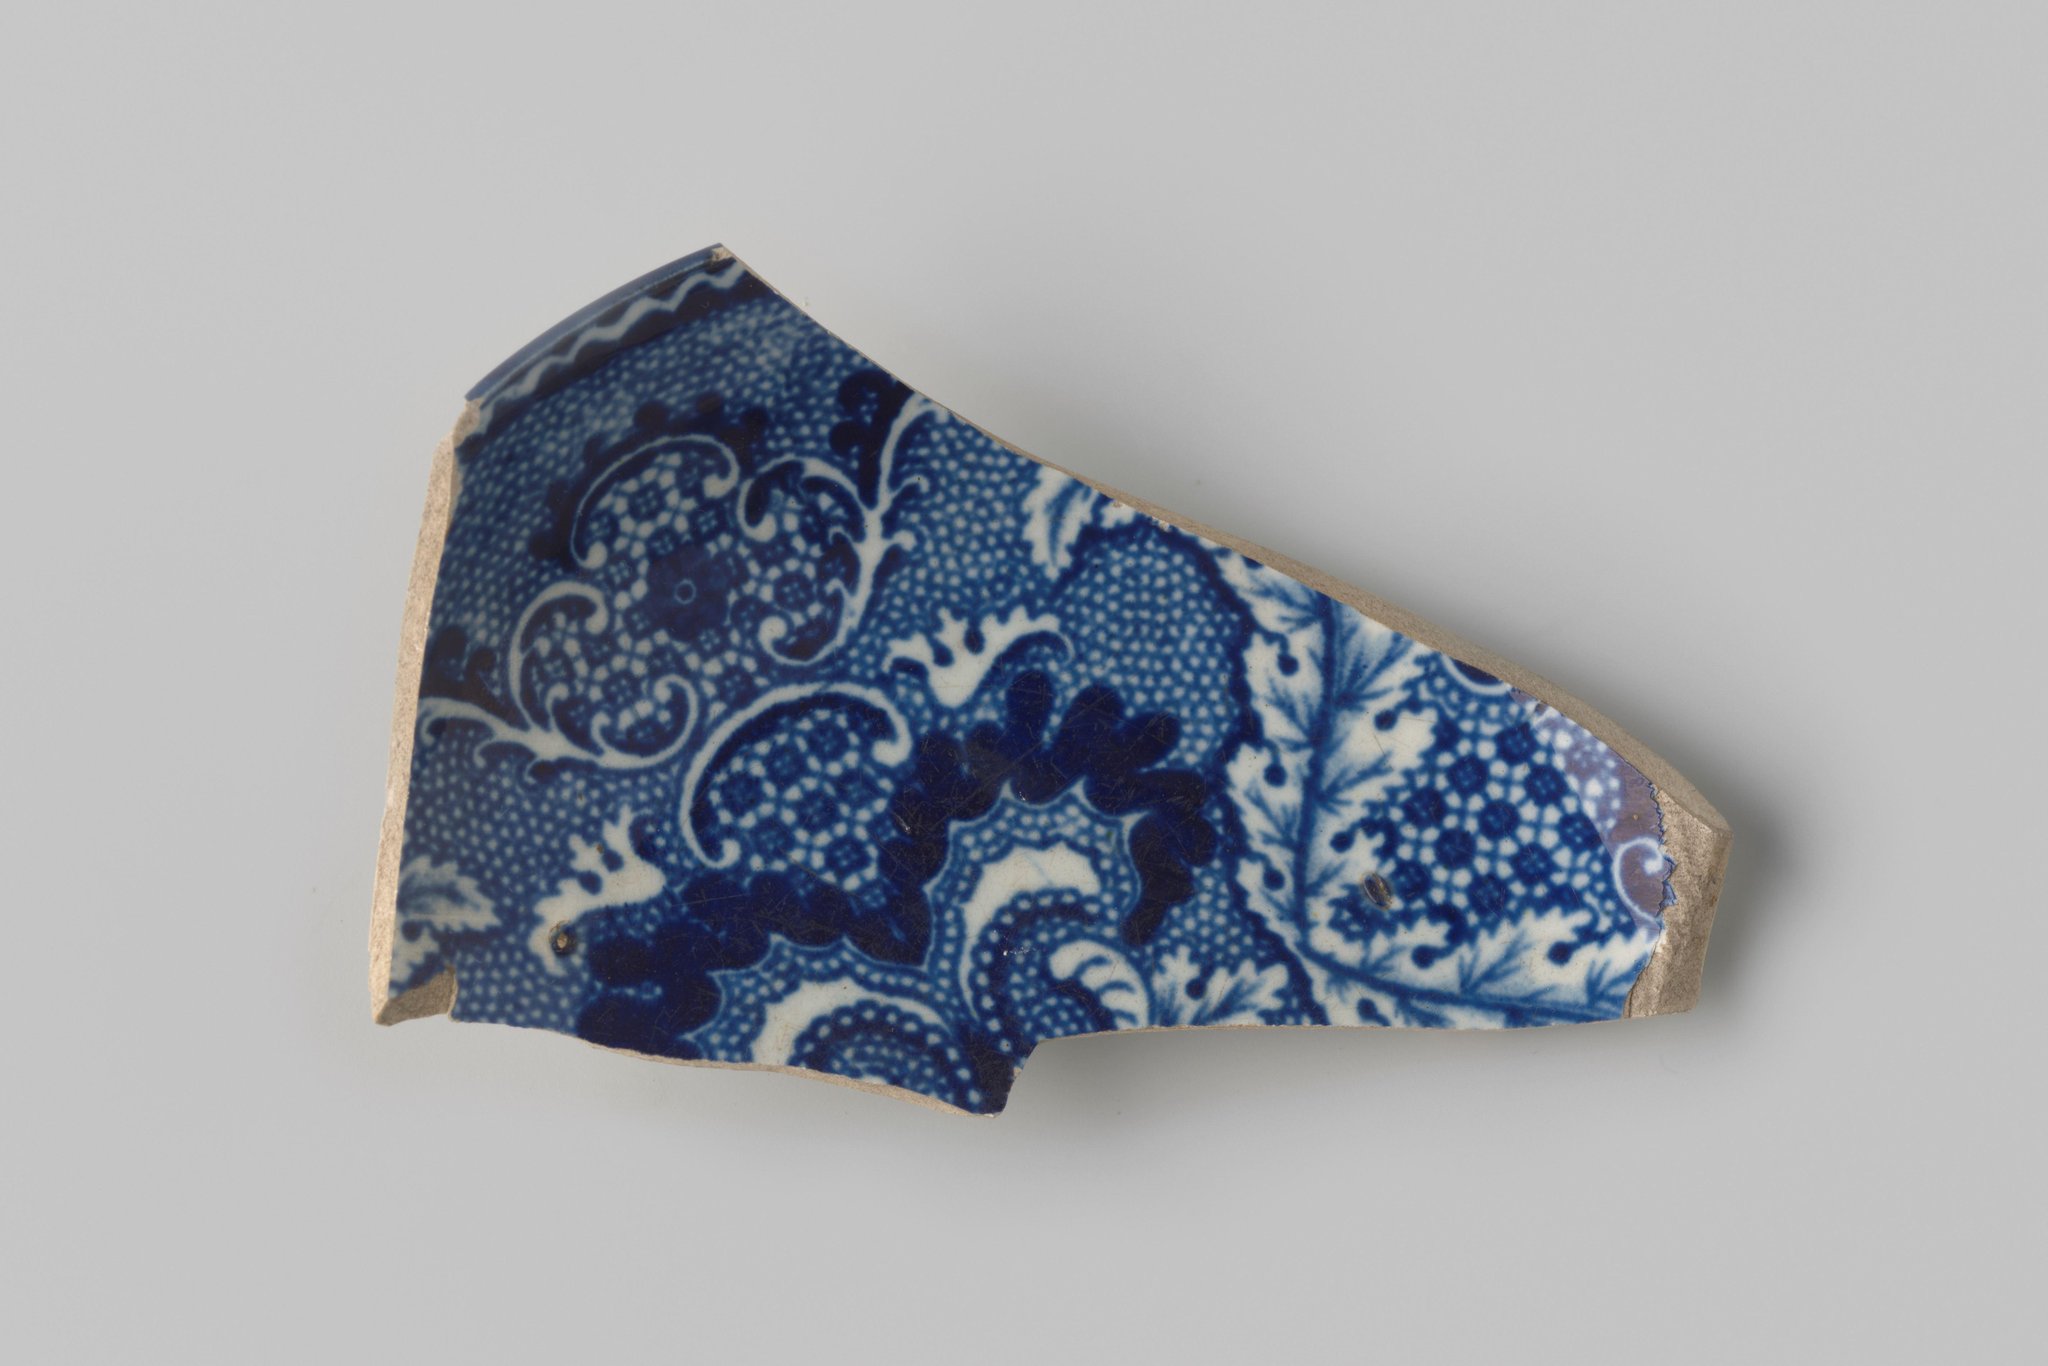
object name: fragment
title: Scherf van een witbakkend aardewerk, met aan de binnenzijde een blauw drukdecor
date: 1500-1899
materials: earthenware, glaze